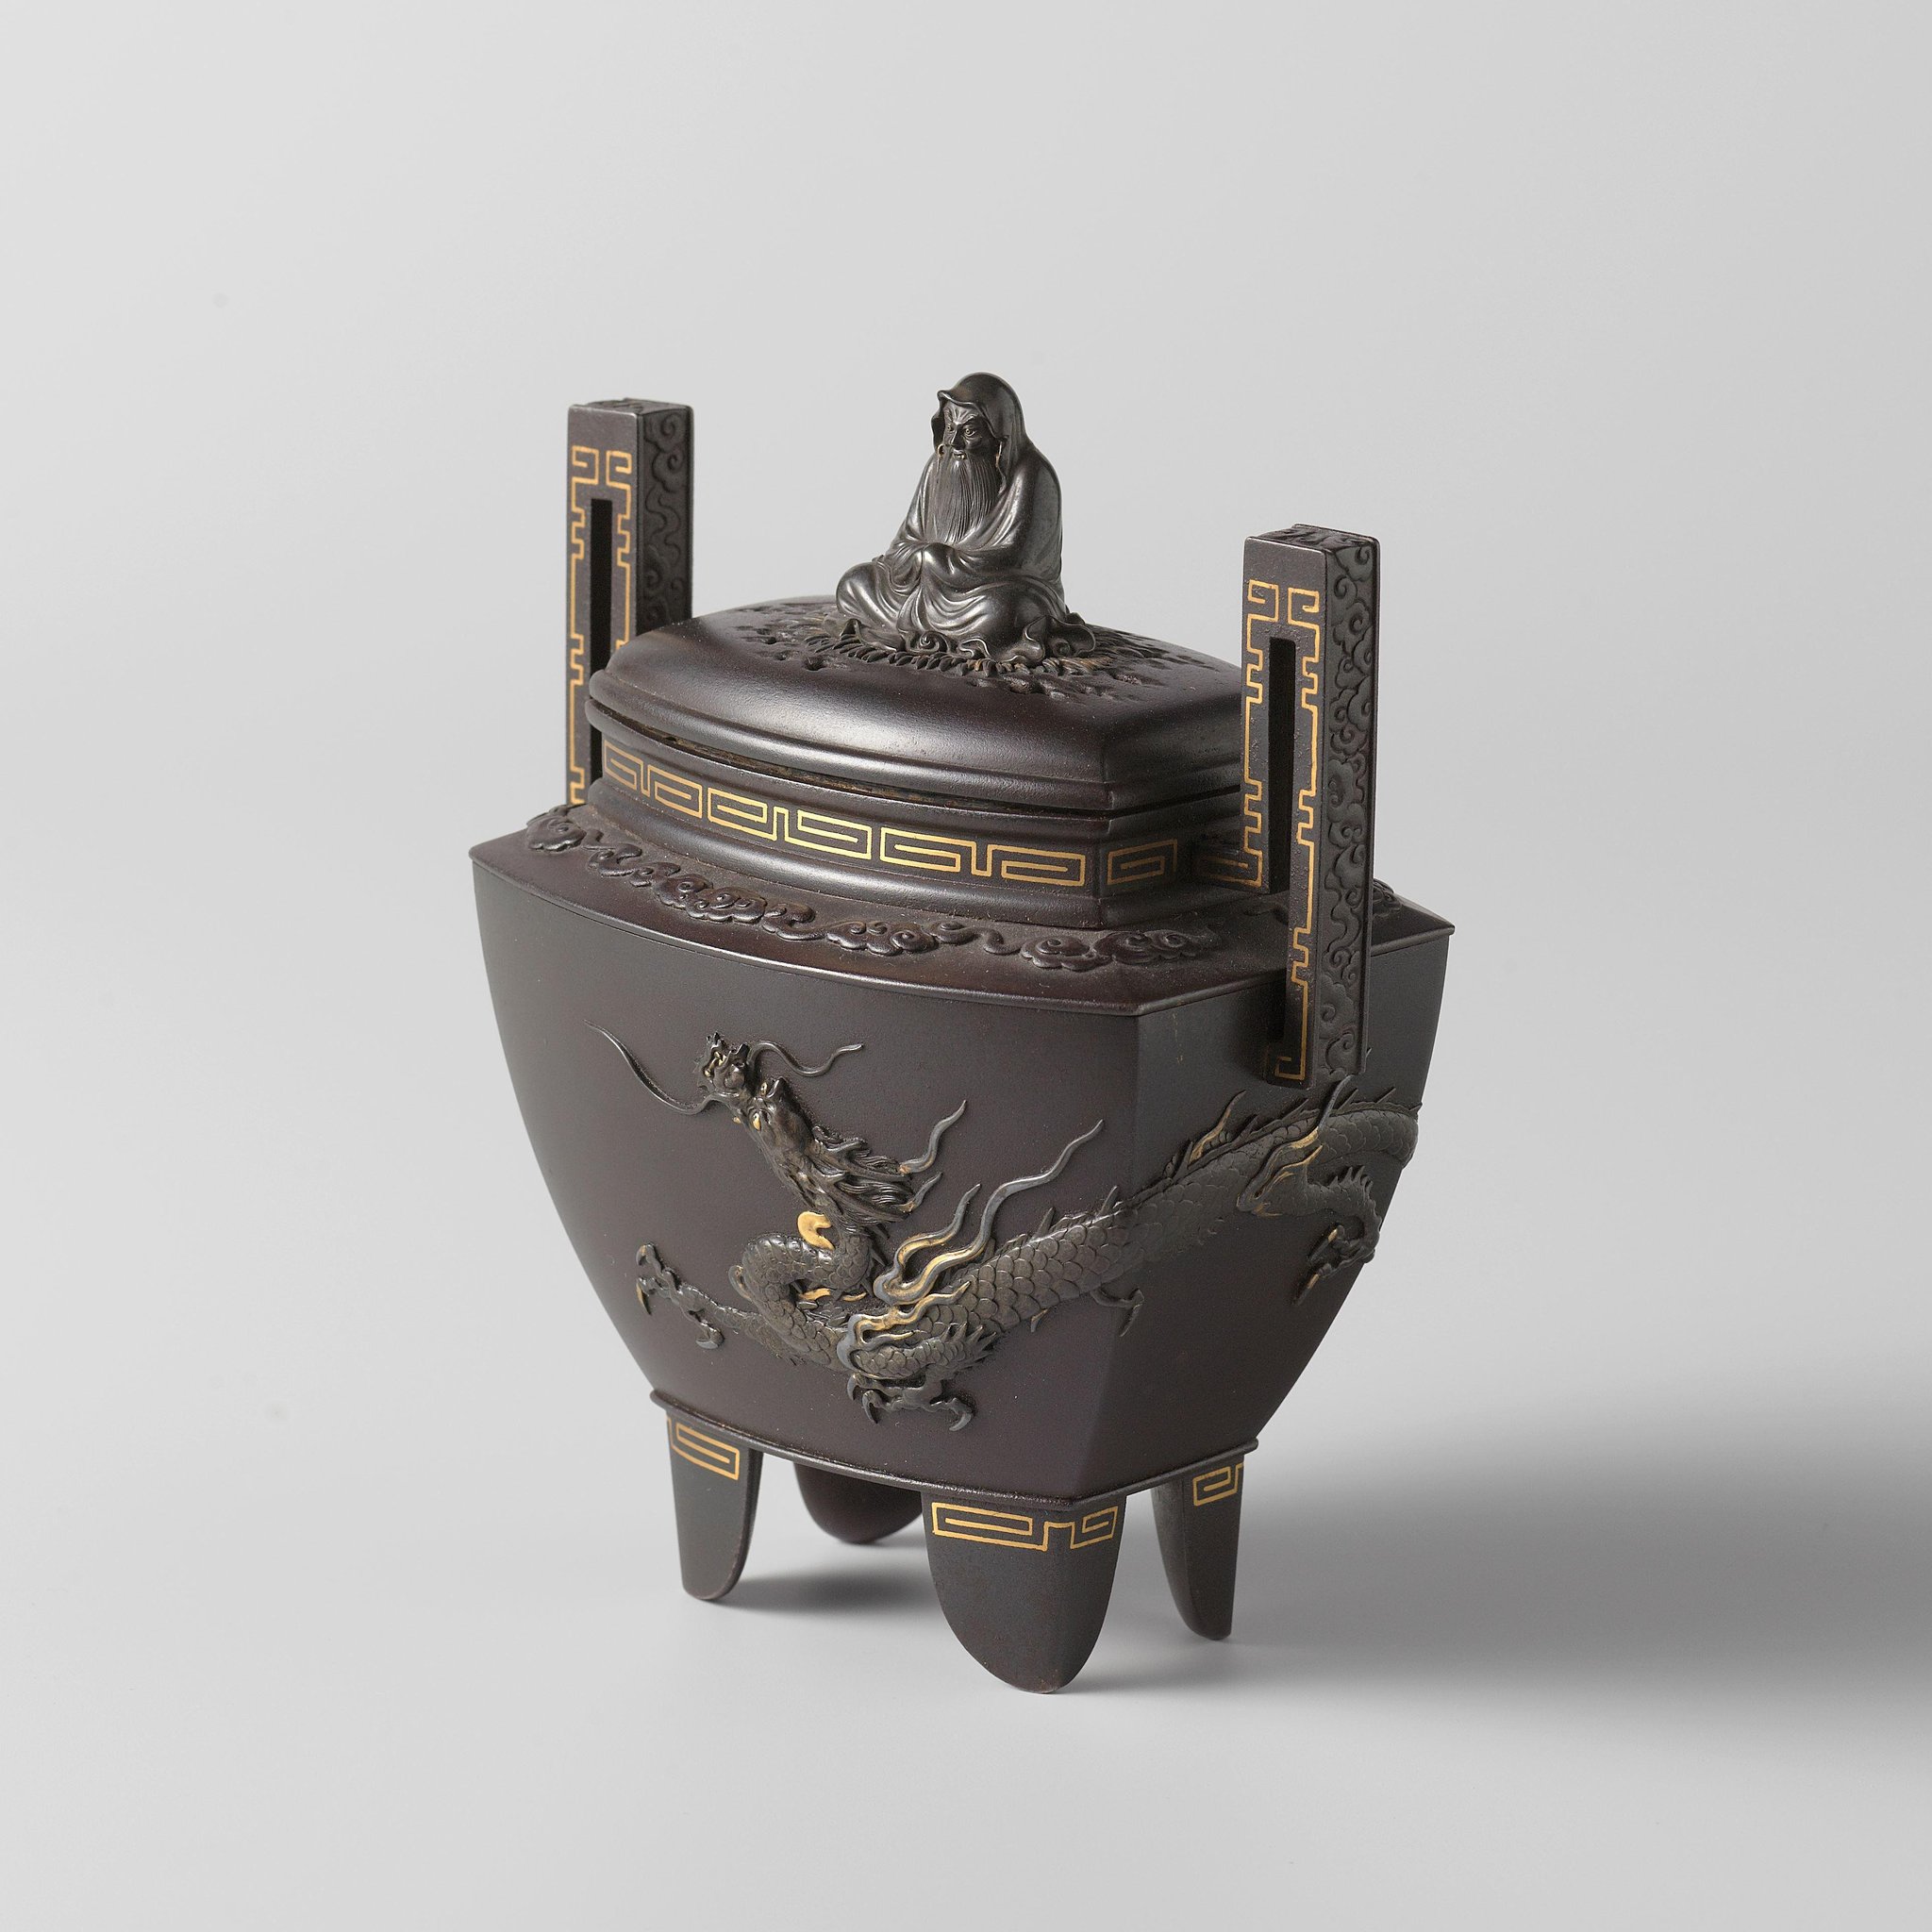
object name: incense burner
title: Wierookbrander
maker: Anonymous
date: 1850-1899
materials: bronze, gold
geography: japan